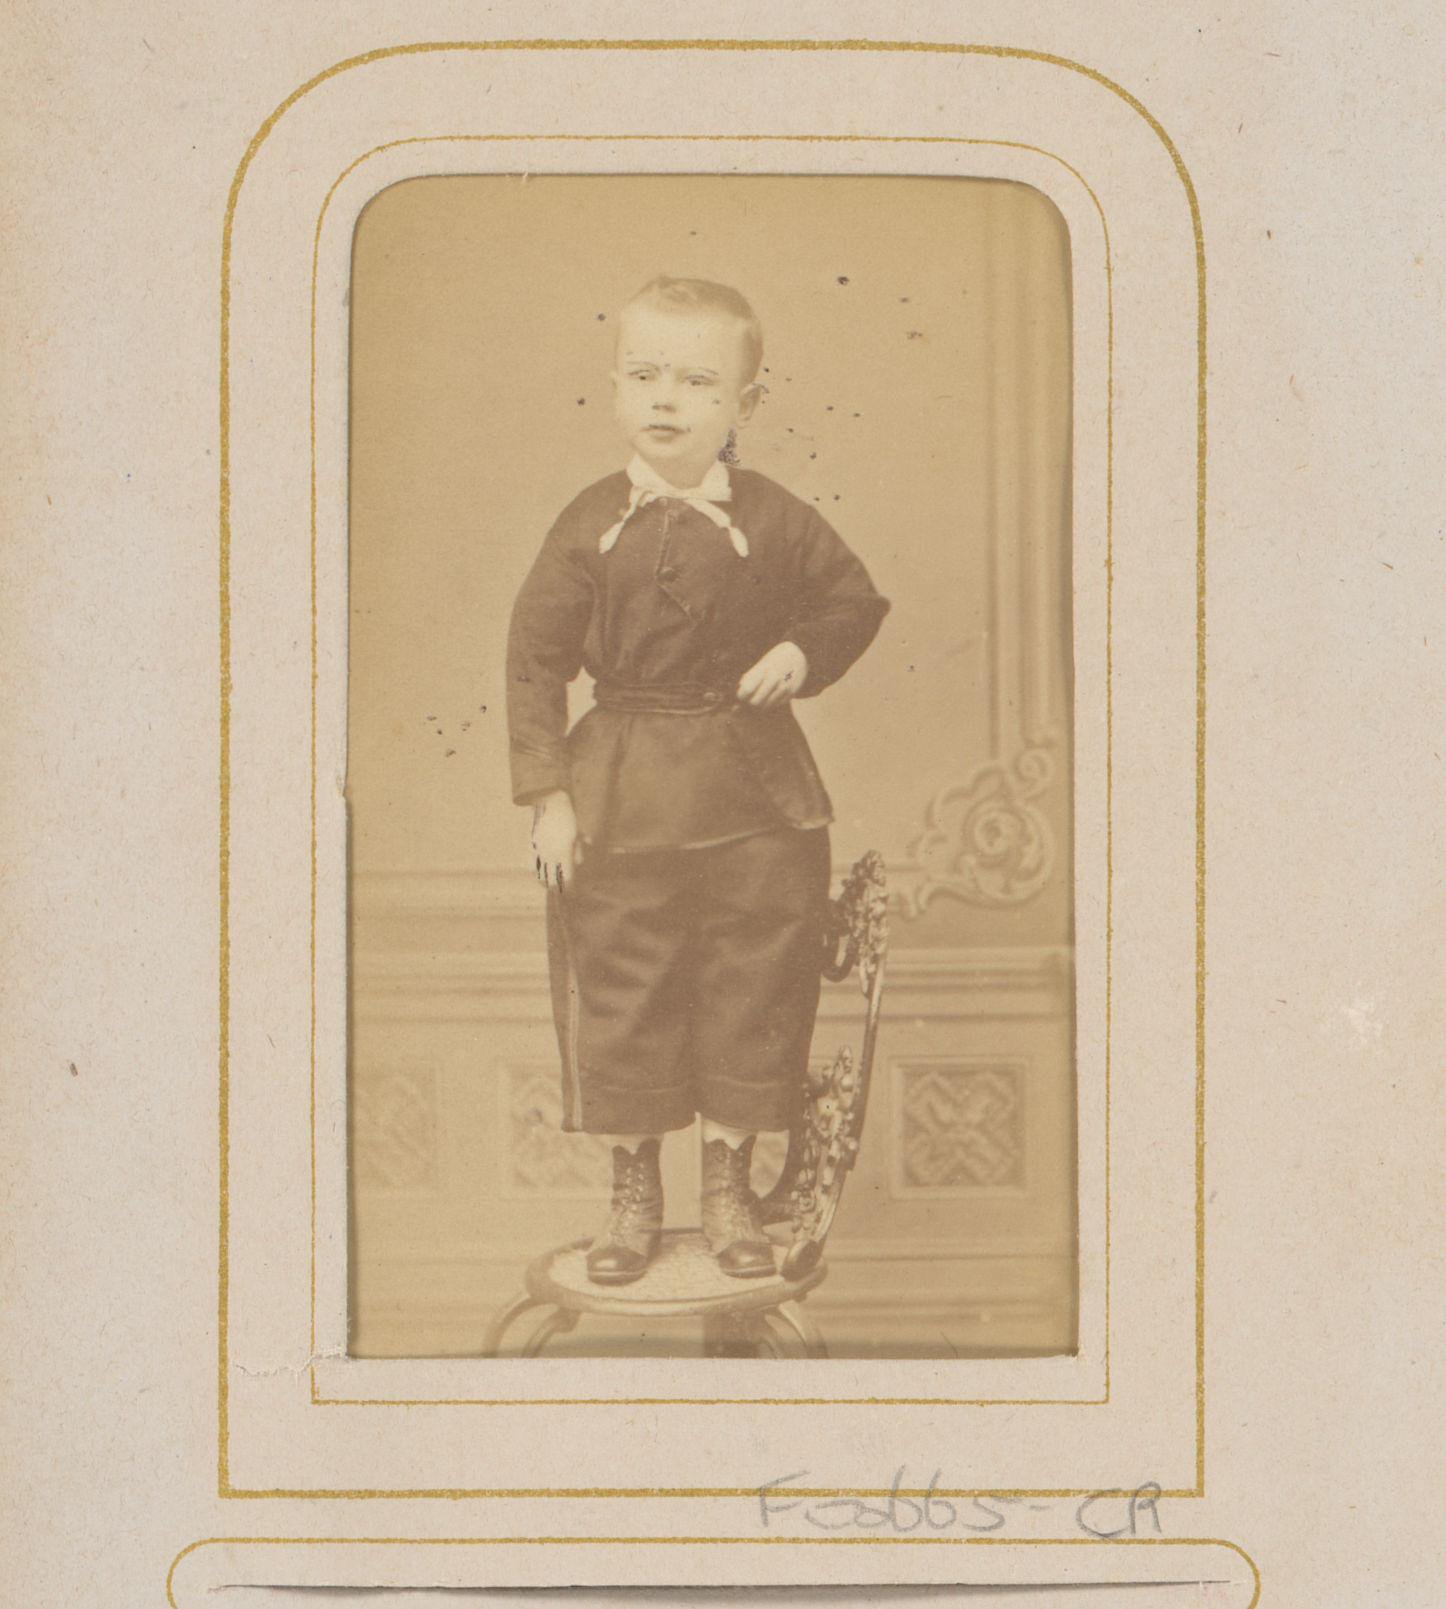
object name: photograph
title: Portret van een kleine jongen staand op stoel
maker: gerarda henriëtte matthijssen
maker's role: draughtsman, painter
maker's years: 1830-1907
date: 1860-1880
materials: cardboard, photographic support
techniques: albumen print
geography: leeuwarden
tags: boy (child between toddler and youth)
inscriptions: inscription: ‘Gerharda H. Matthijssen/ Photographe/ Leeuwarden/ Naauw H.46 en St. Jacobstraat H.50’